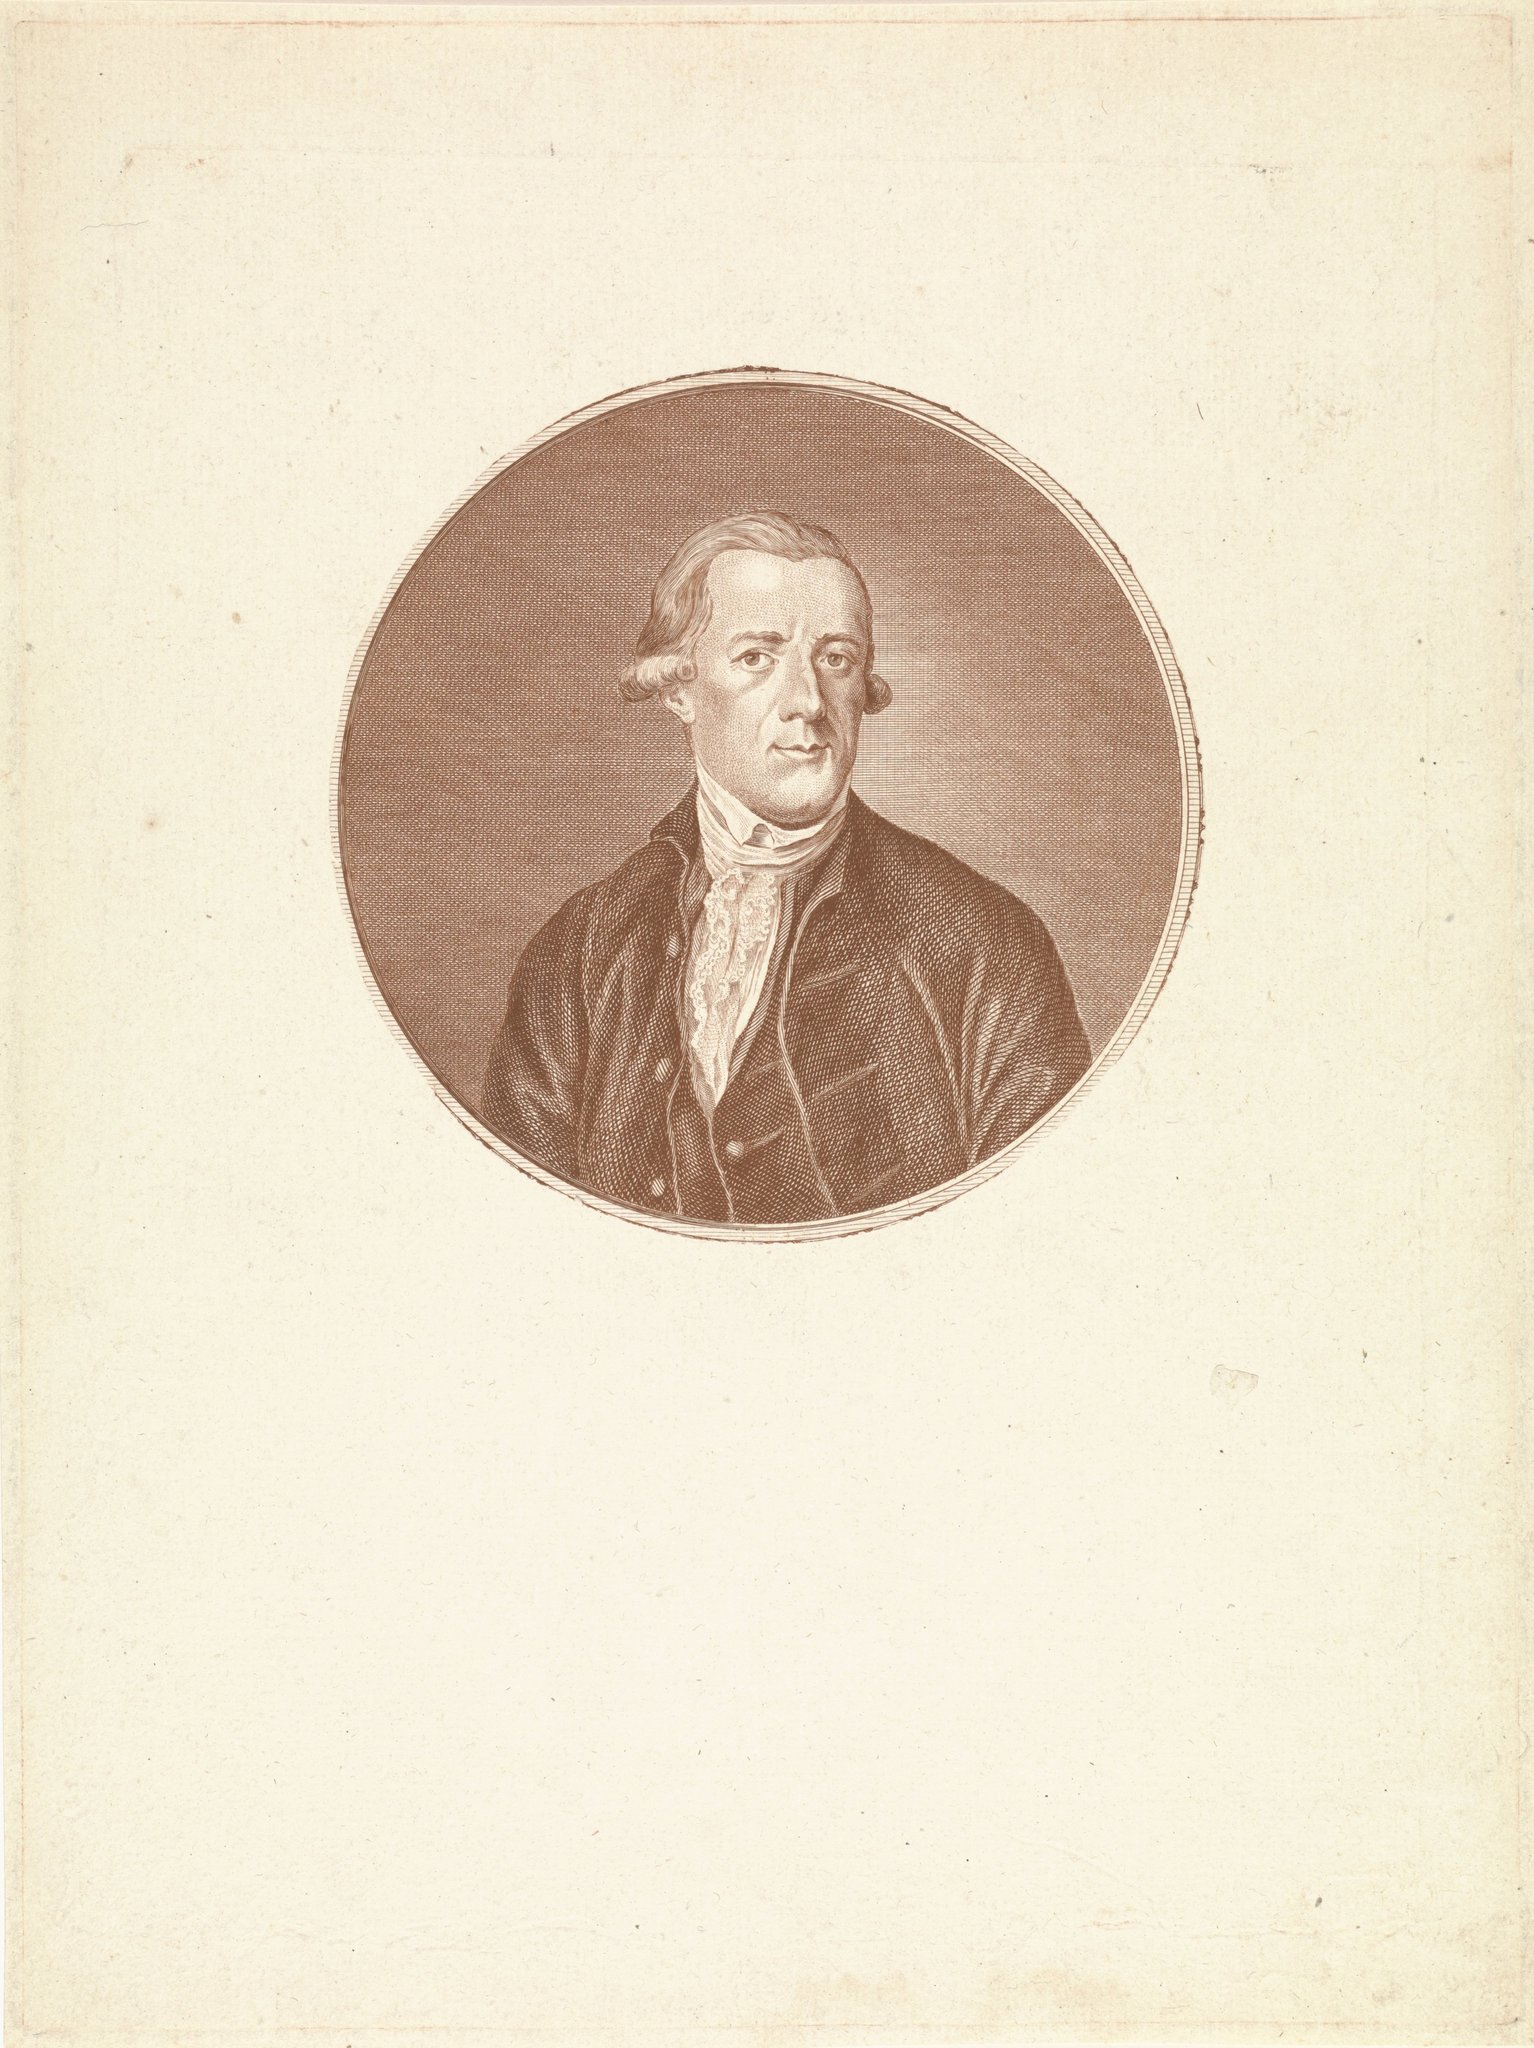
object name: print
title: Portret van de politicus Joan Derk van der Capellen tot den Pol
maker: mathias de sallieth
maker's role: print maker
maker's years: 1749-1791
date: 1787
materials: paper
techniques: engraving, etching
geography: rotterdam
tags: politician, joan derk van der capellen tot den pol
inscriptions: collector's mark: Lugt 2228